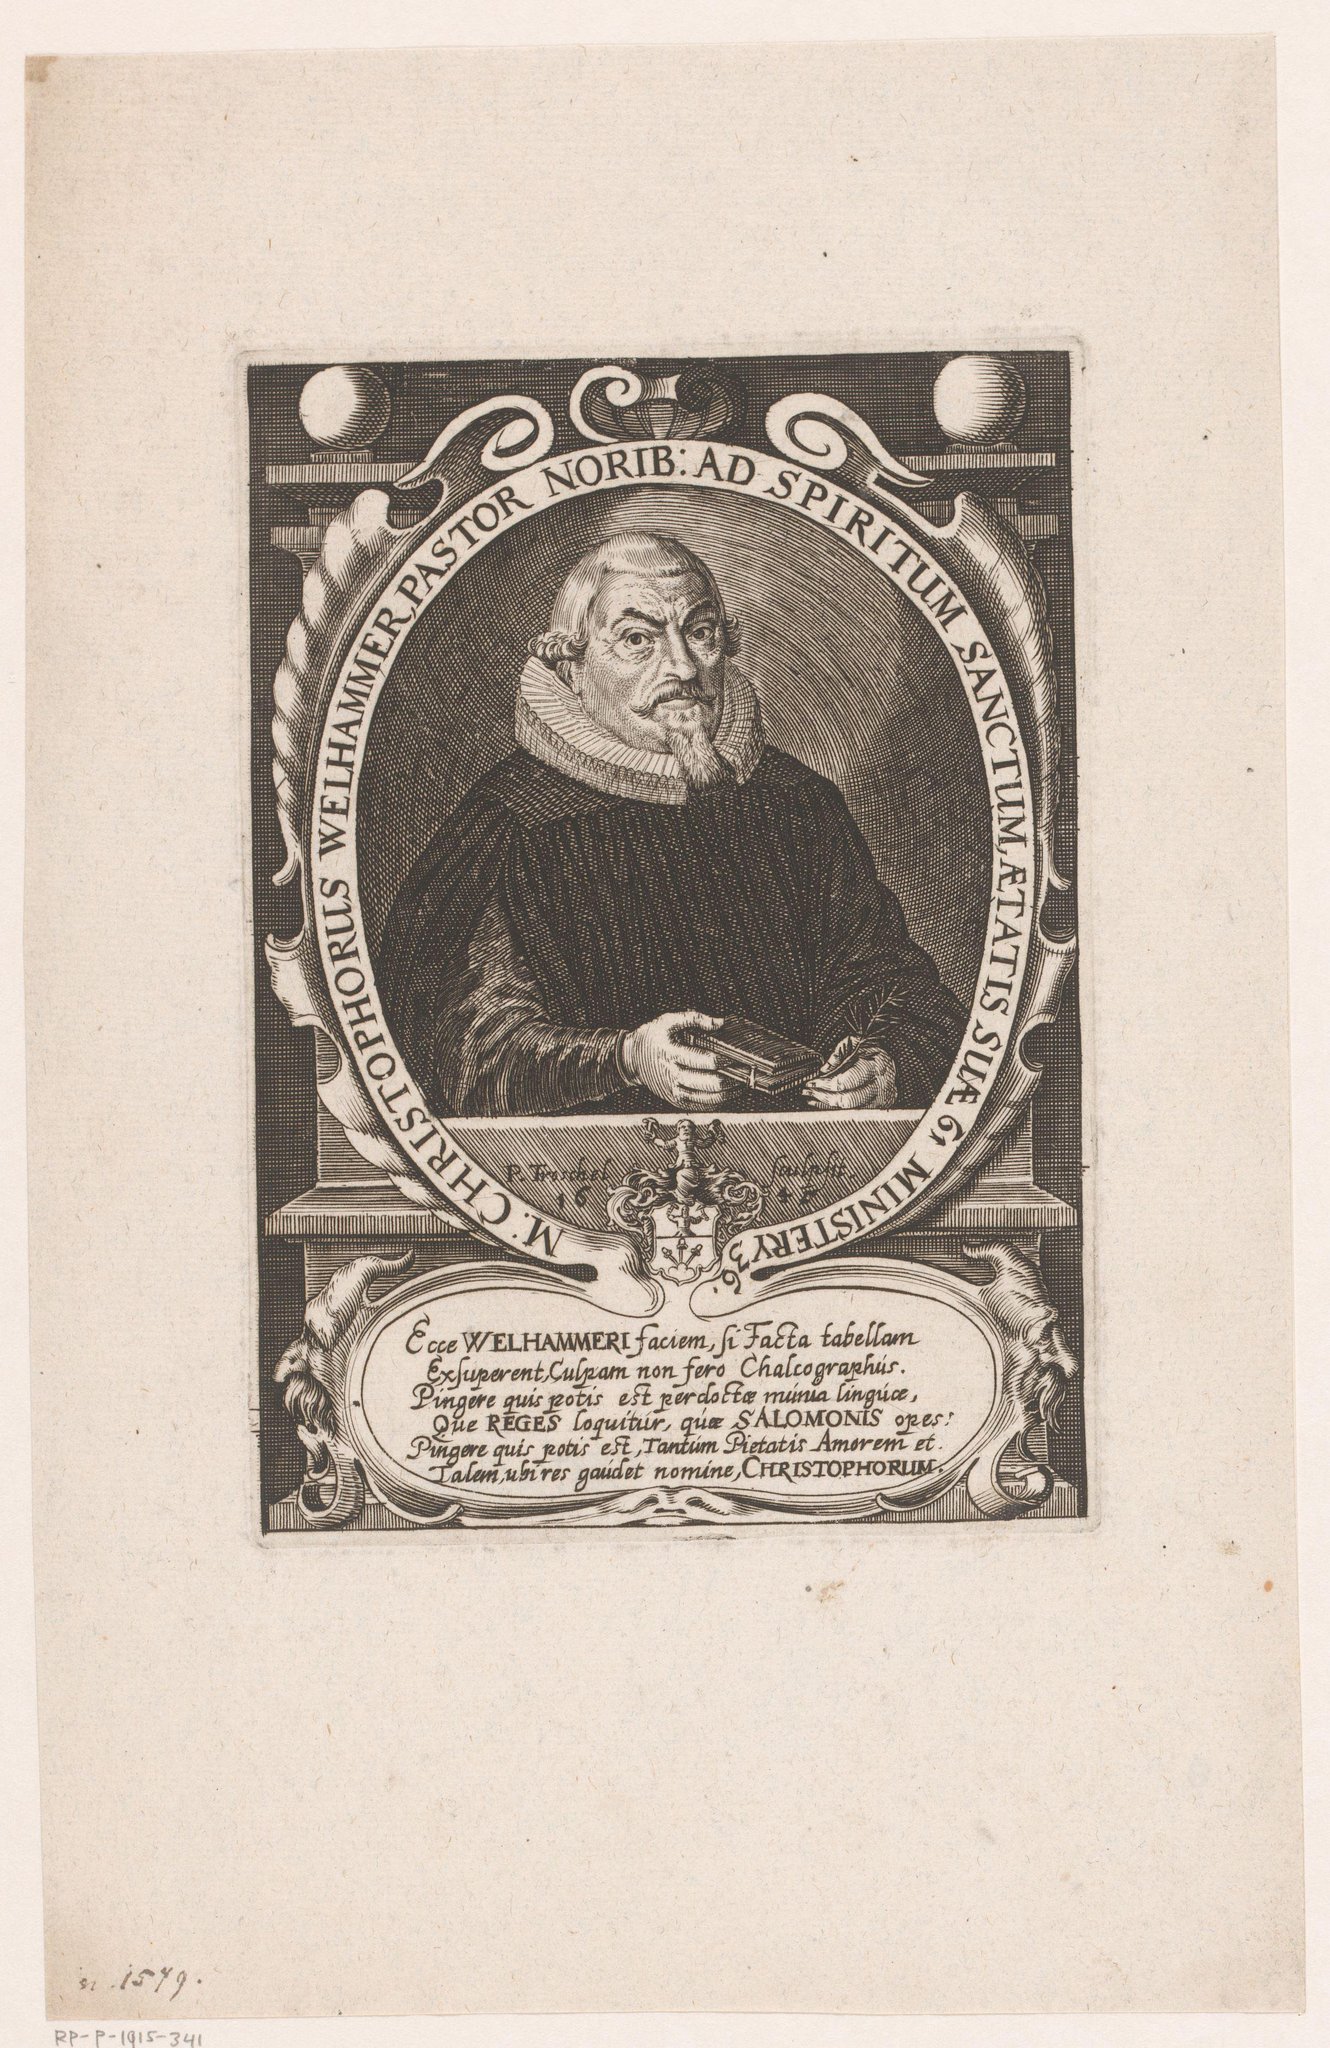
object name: print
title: Portret van Christoph Welhamer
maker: peter troschel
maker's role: draughtsman, print maker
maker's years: 1620-1670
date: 1645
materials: paper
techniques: engraving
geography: germany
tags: amberg, historical persons, armorial bearing, heraldry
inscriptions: collector's mark: Lugt 2228